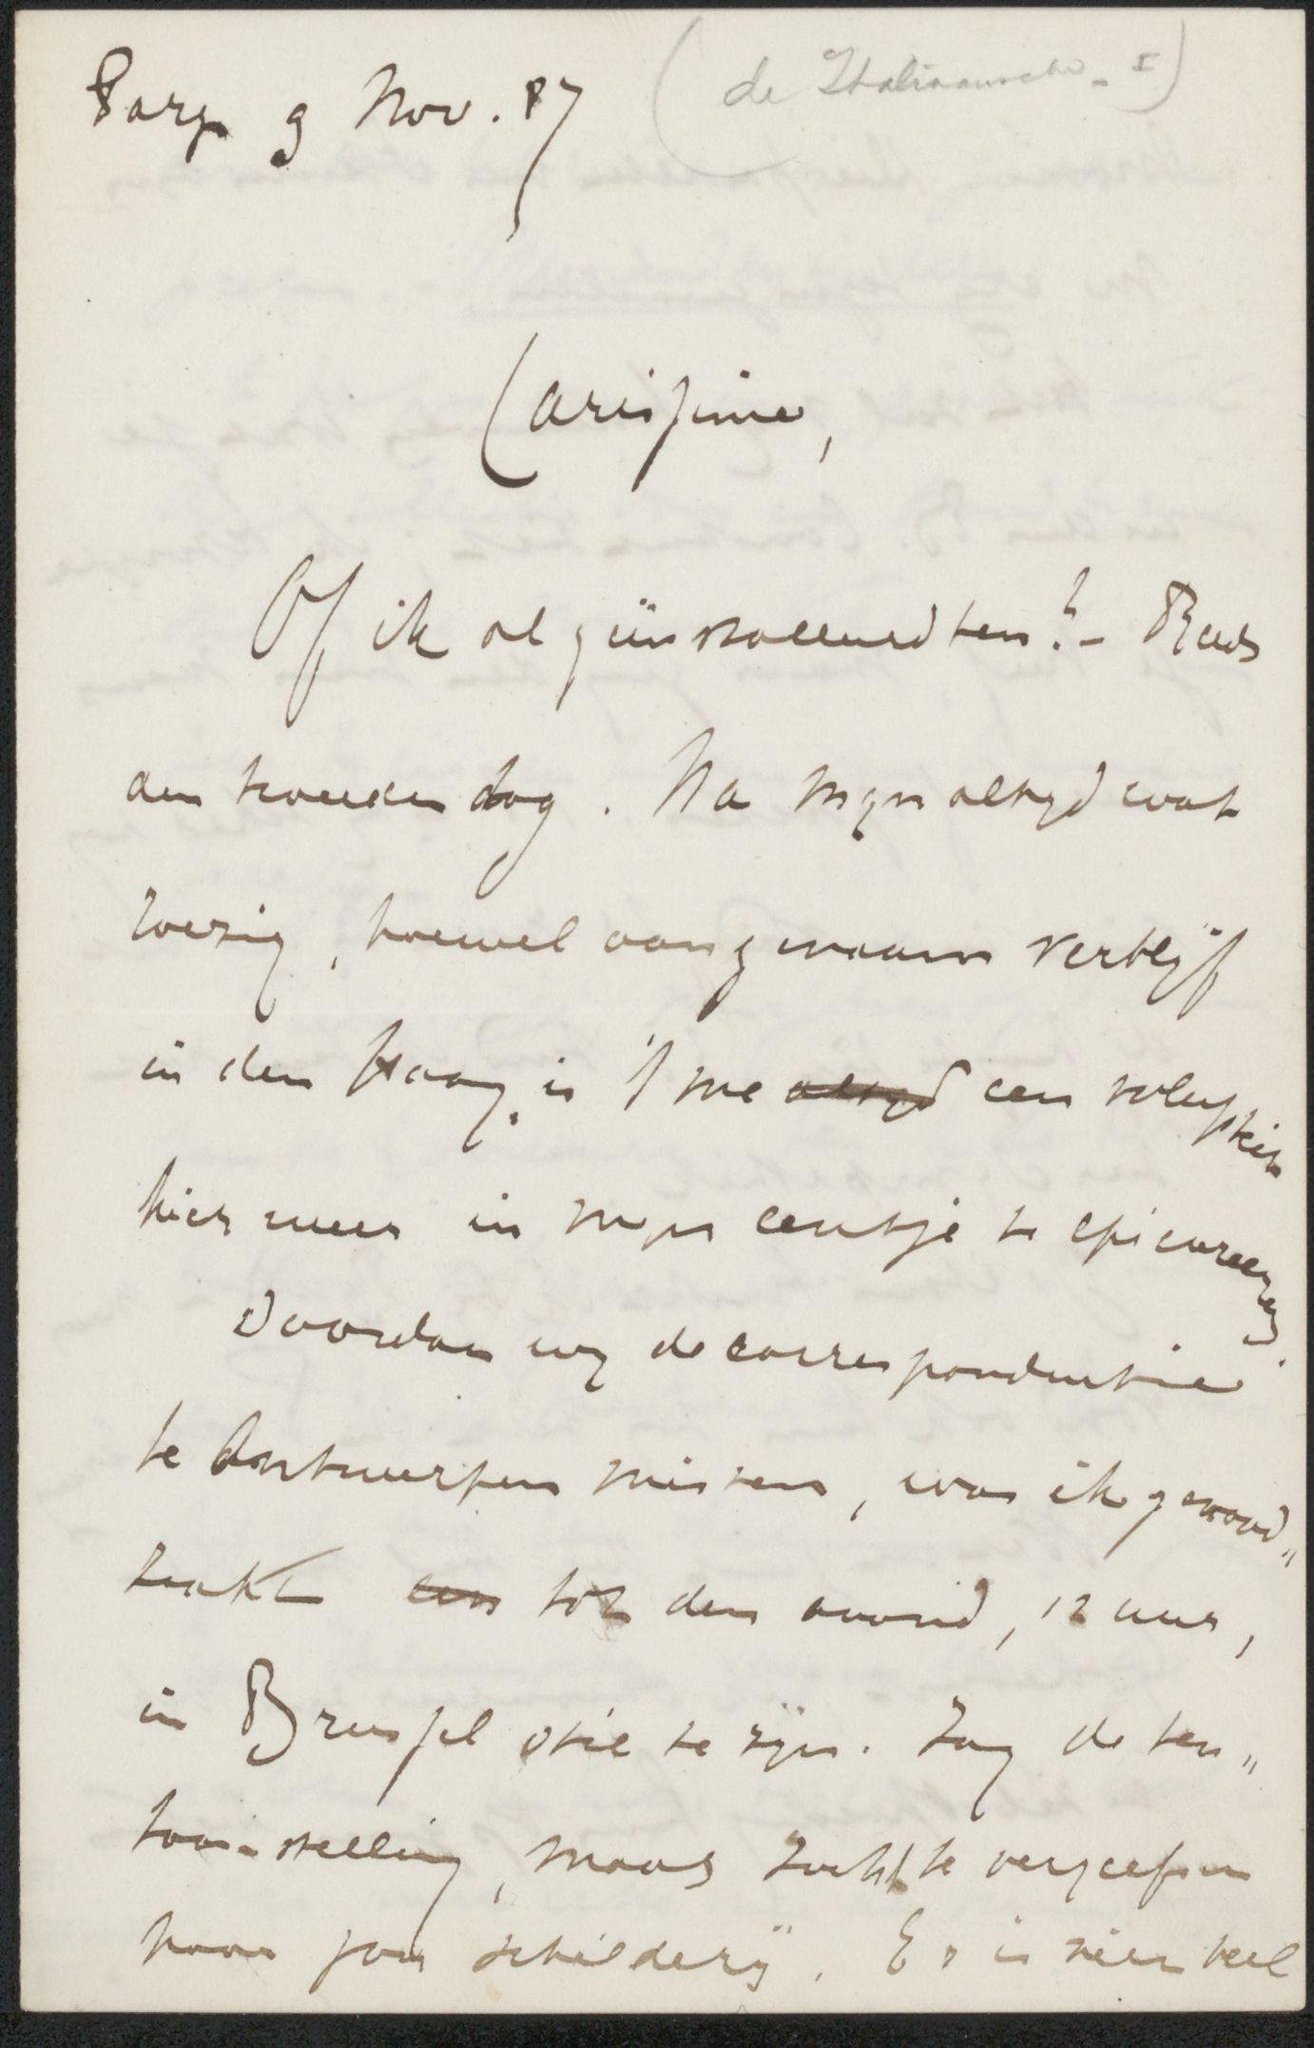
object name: letter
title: Brief aan Philip Zilcken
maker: adriaan pit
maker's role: print maker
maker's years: 1860-1944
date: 1887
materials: ink, paper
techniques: pen, writing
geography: paris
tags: paris, alfred stevens, marinus van der maarel, félix hilaire buhot, painter, draughtsman, edmond de goncourt, jean-joseph benjamin-constant, philip zilcken, the graphic arts, painting (including book-illumination, miniature-painting), exhibition ~ art, the hague, antwerp, brussels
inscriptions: watermark, collector's mark: ‘RPK’